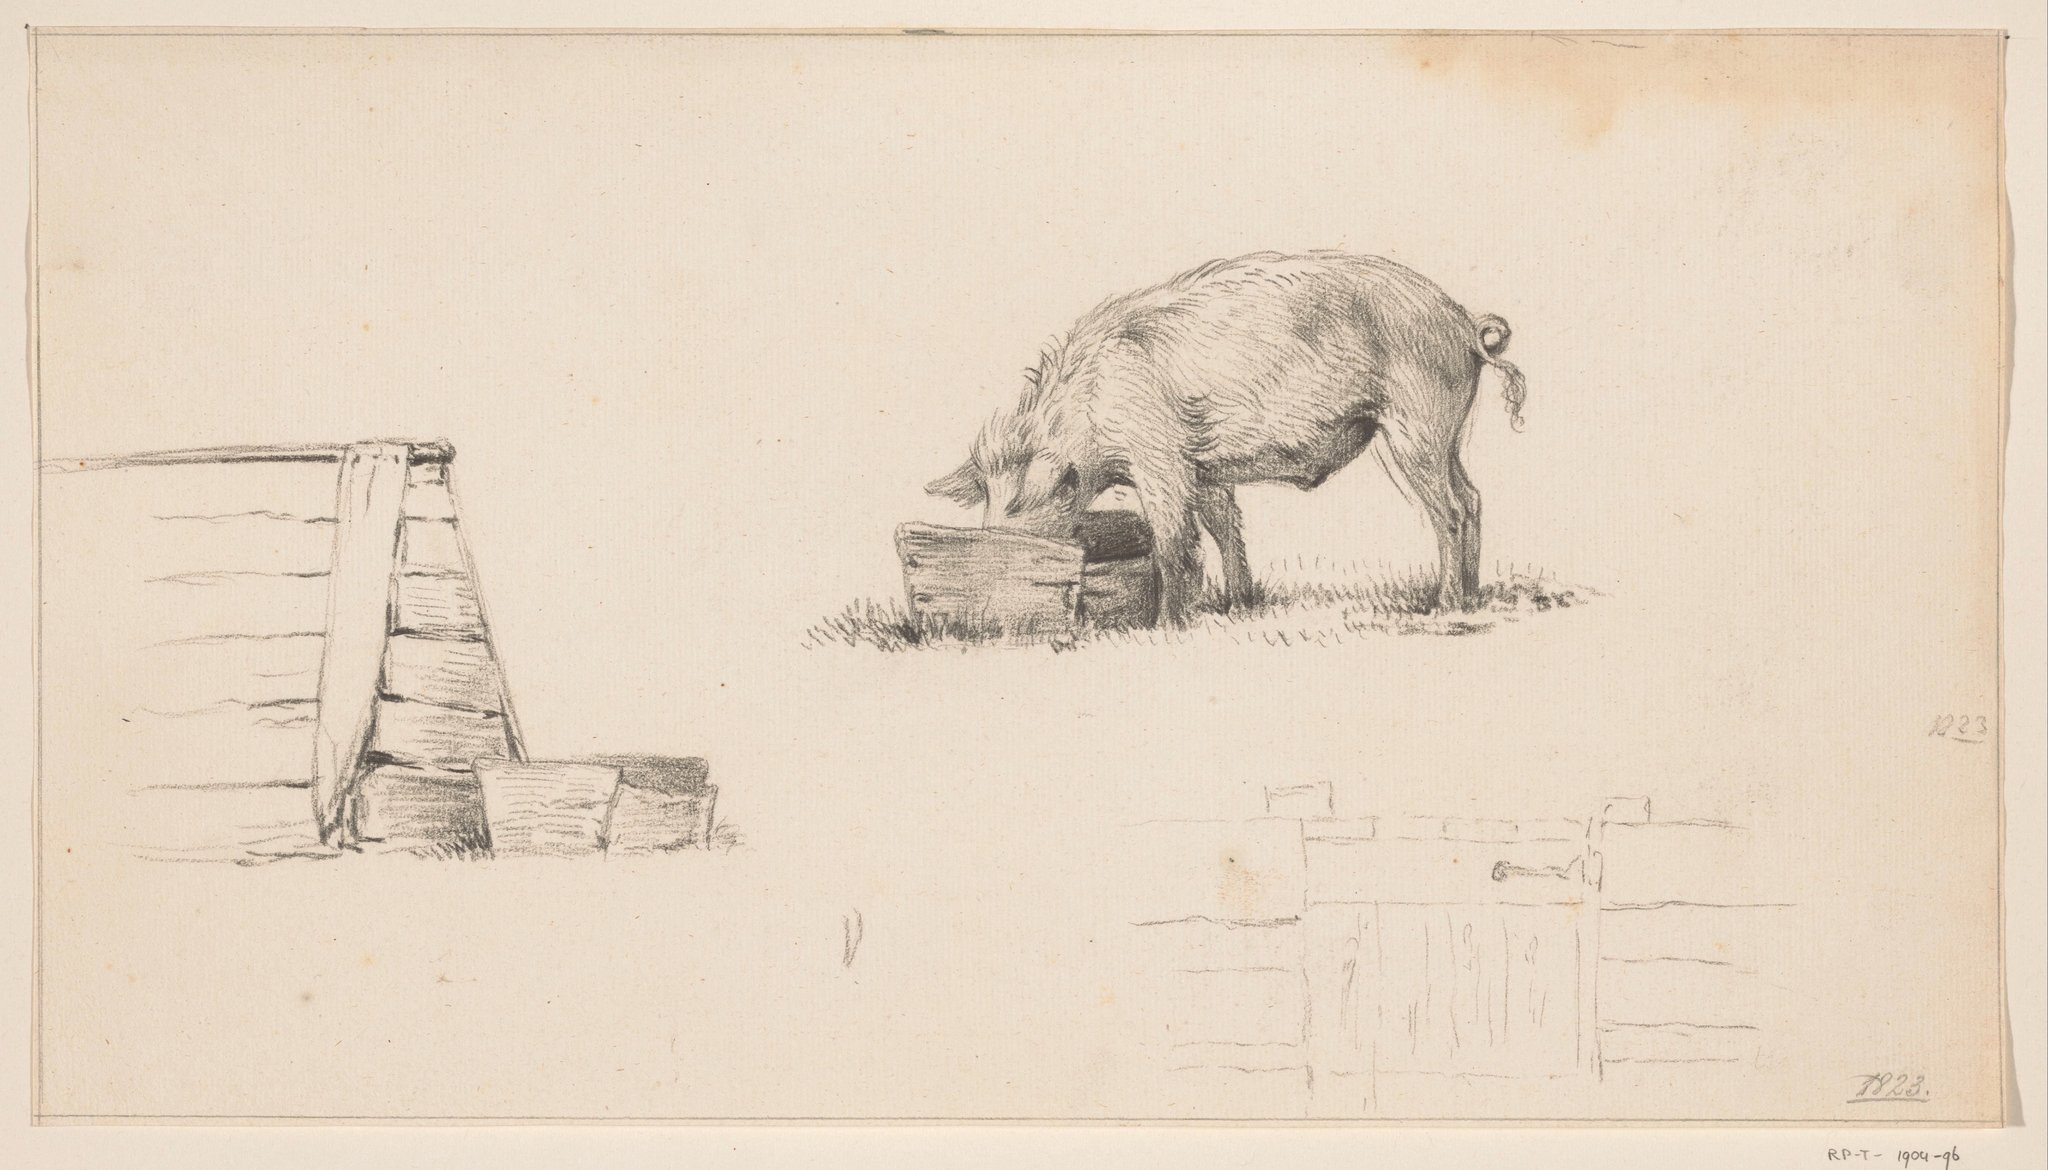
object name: drawing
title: Varken, een hok en een schets van een hek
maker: jean bernard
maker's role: draughtsman, print maker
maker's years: 1765-1833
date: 1823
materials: chalk, paper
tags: pig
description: Blad met een varken, etend uit een trog, een hok en een schets van een hek.